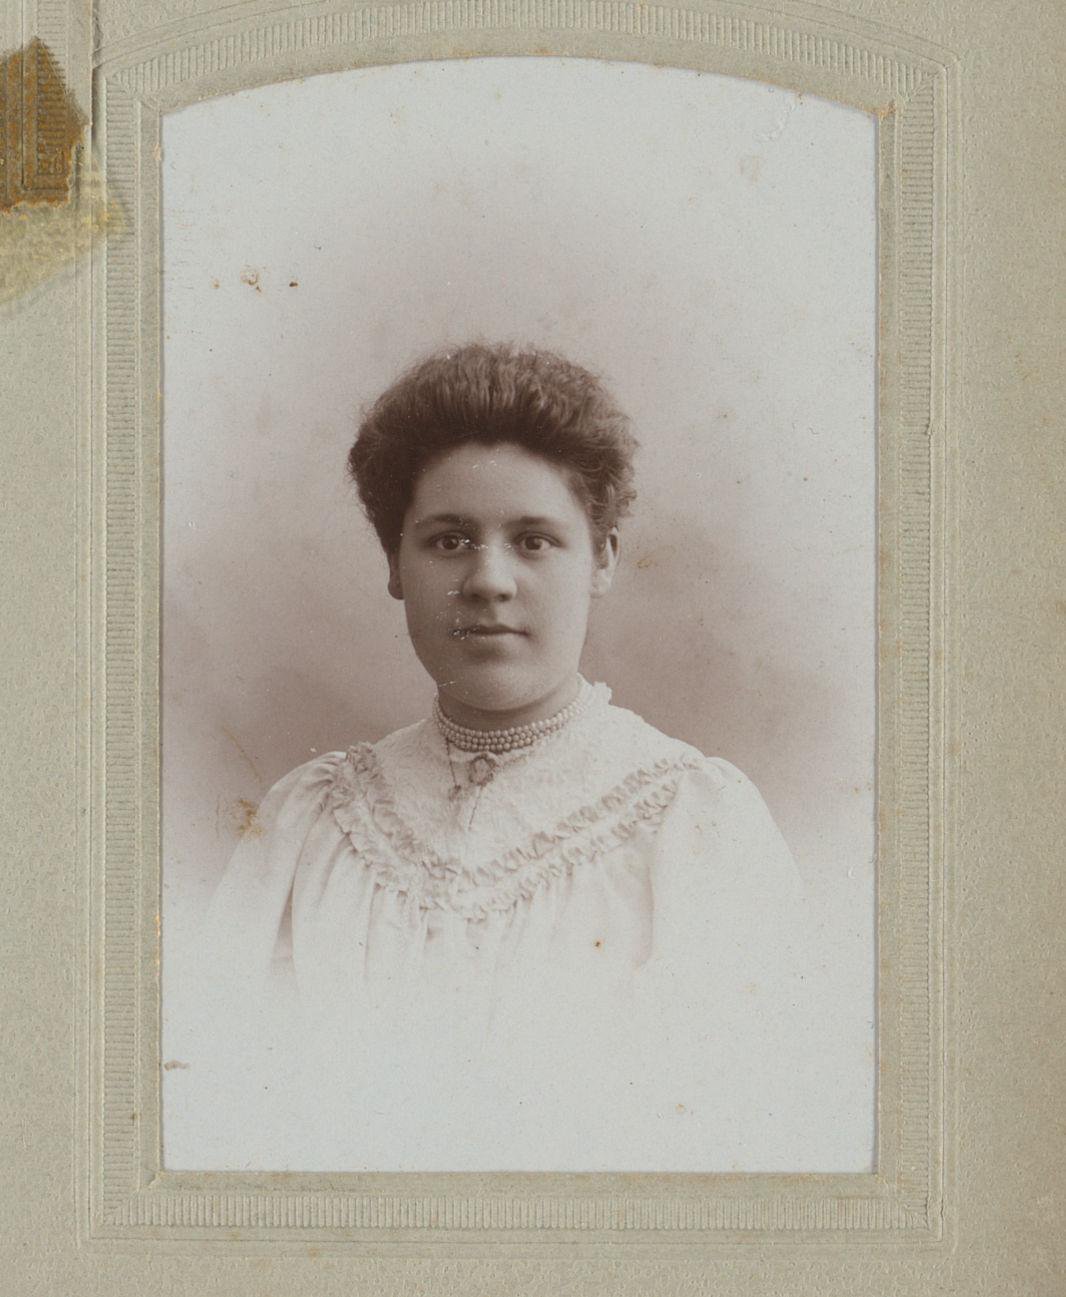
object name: album leaf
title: Portret van een vrouw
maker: machiel hendricus laddé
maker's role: fotograaf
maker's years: 1866-1932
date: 1890-1910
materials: cardboard, photographic support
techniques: collodion silver print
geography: amsterdam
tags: adult woman, historical persons